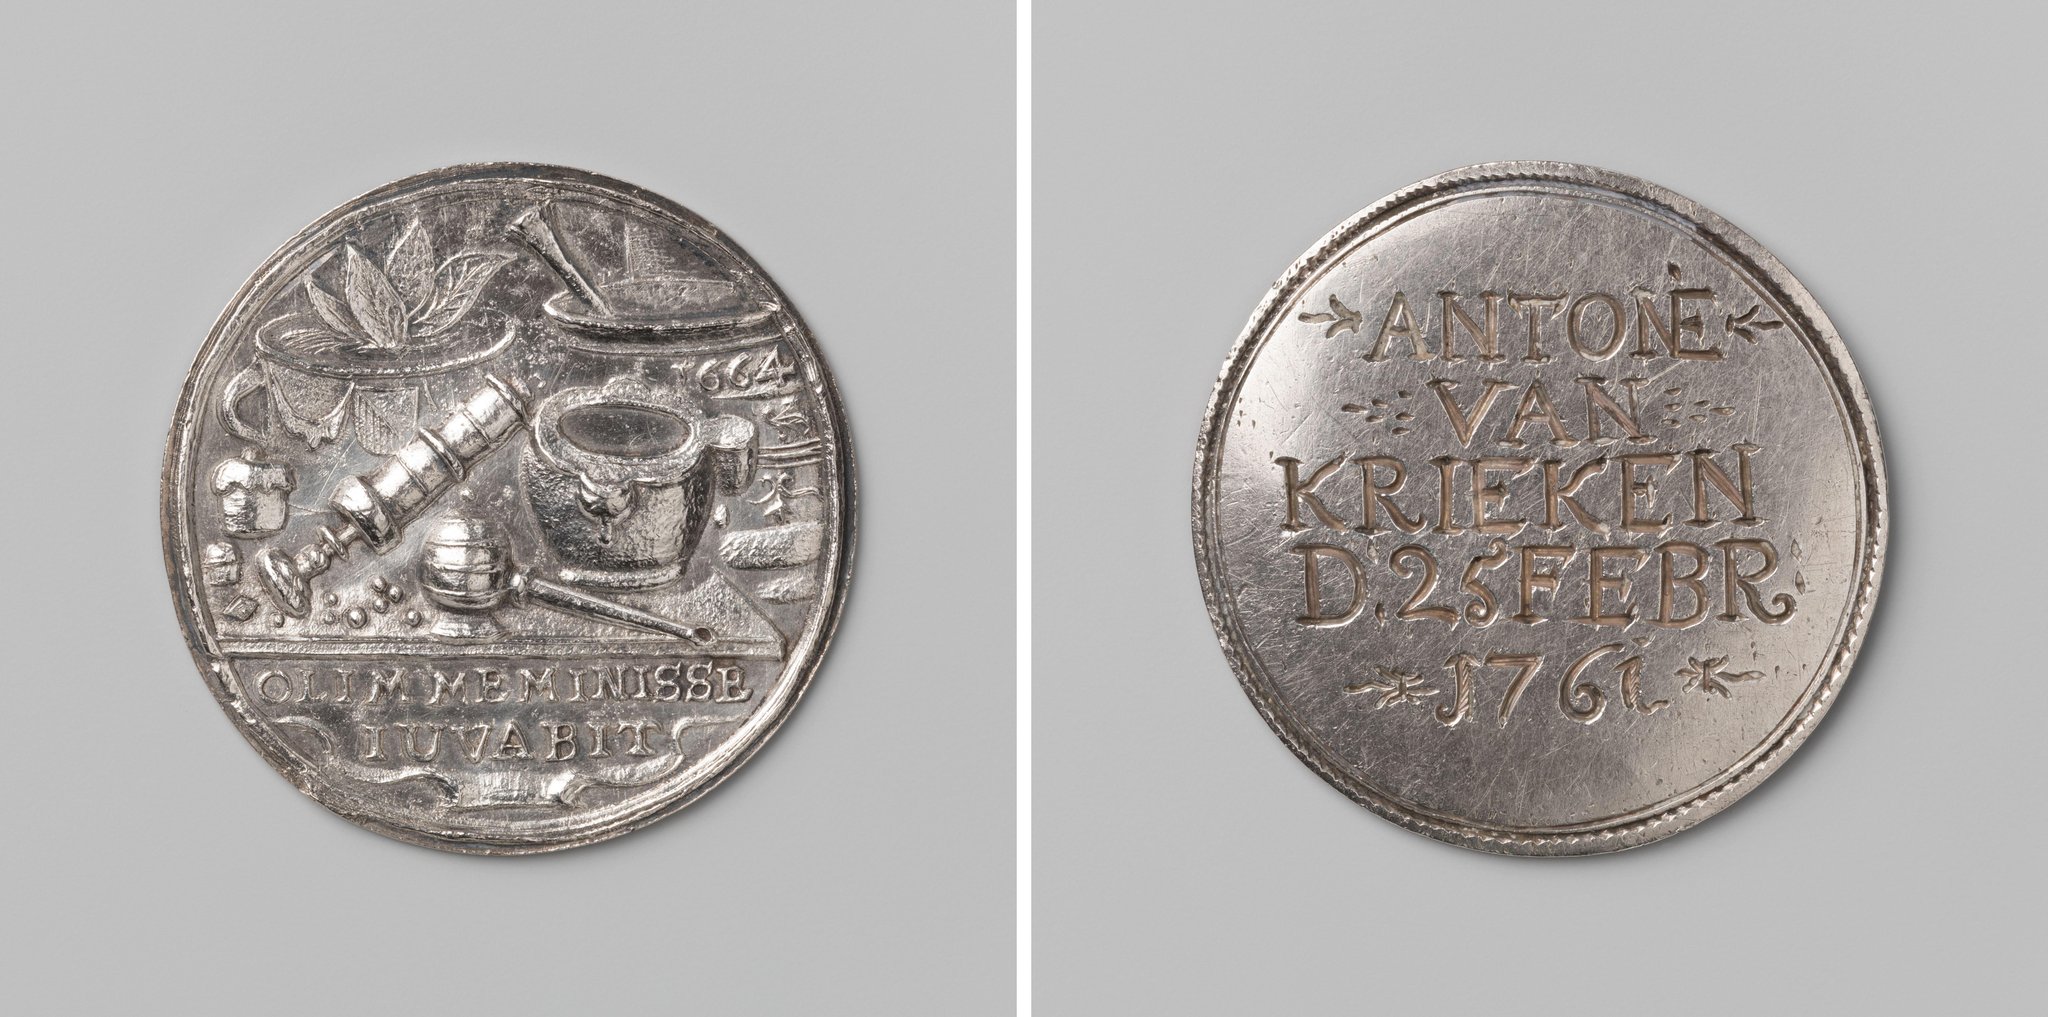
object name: medal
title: Apothekersgilde van Utrecht, gildepenning van Antonie van Krieken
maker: hendrik winter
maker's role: jeweler, print maker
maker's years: 1620-1677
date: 1665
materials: silver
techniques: casting, engraving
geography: utrecht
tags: utrecht